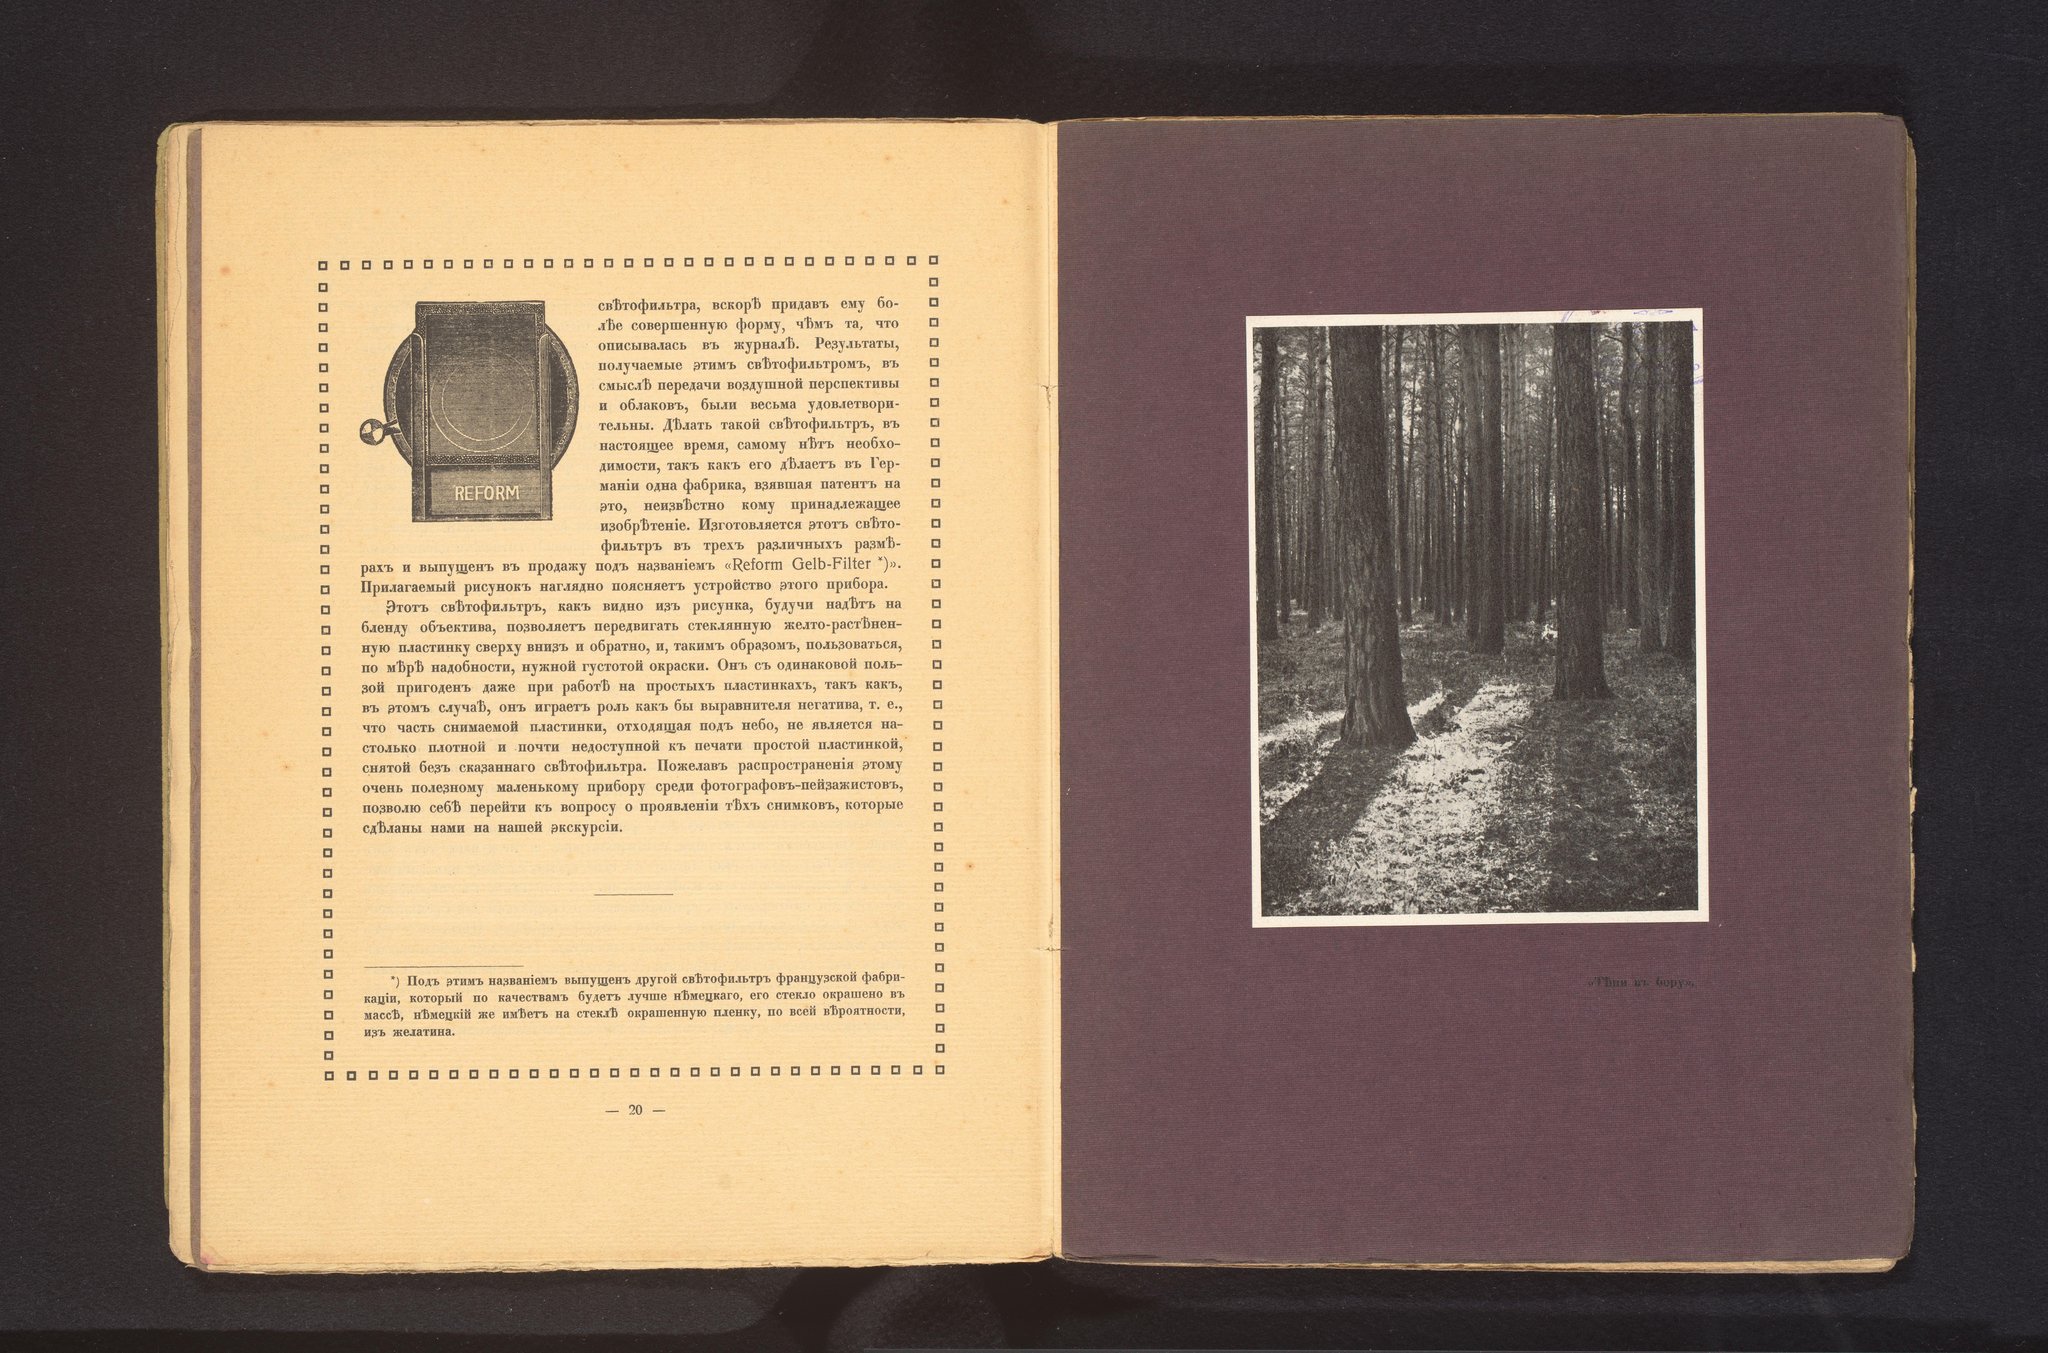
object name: page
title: Bomen in een bos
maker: Anonymous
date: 1897-1907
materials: paper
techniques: autotype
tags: trees, forest, wood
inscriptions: inscription